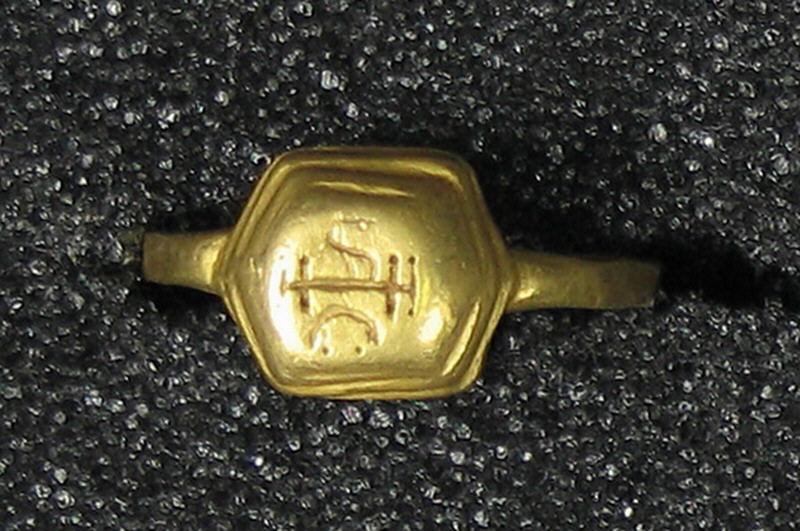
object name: ring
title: Ring with Rectangular Bezel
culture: indonesian, central java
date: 701-1200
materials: gold